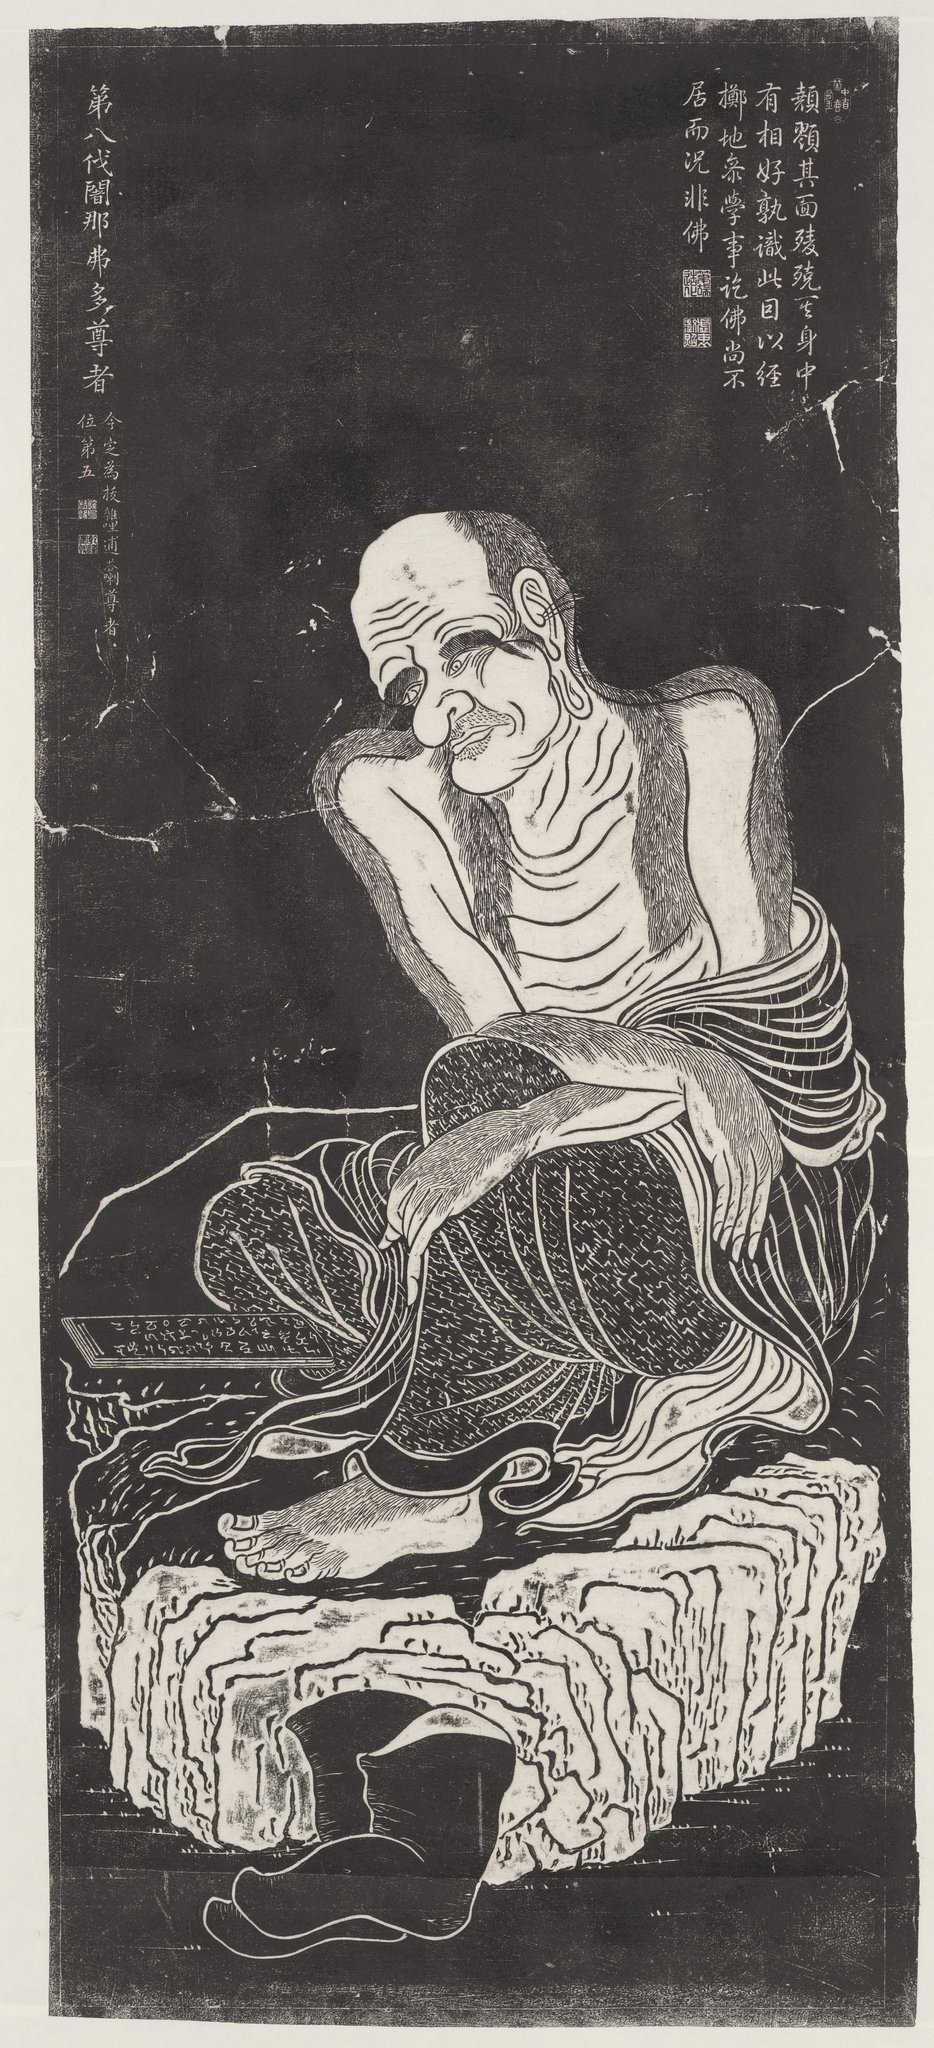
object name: rubbing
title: Luohan, after a set attributed to Guanxiu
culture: chinese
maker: unidentified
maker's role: artist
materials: ink, paper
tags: men